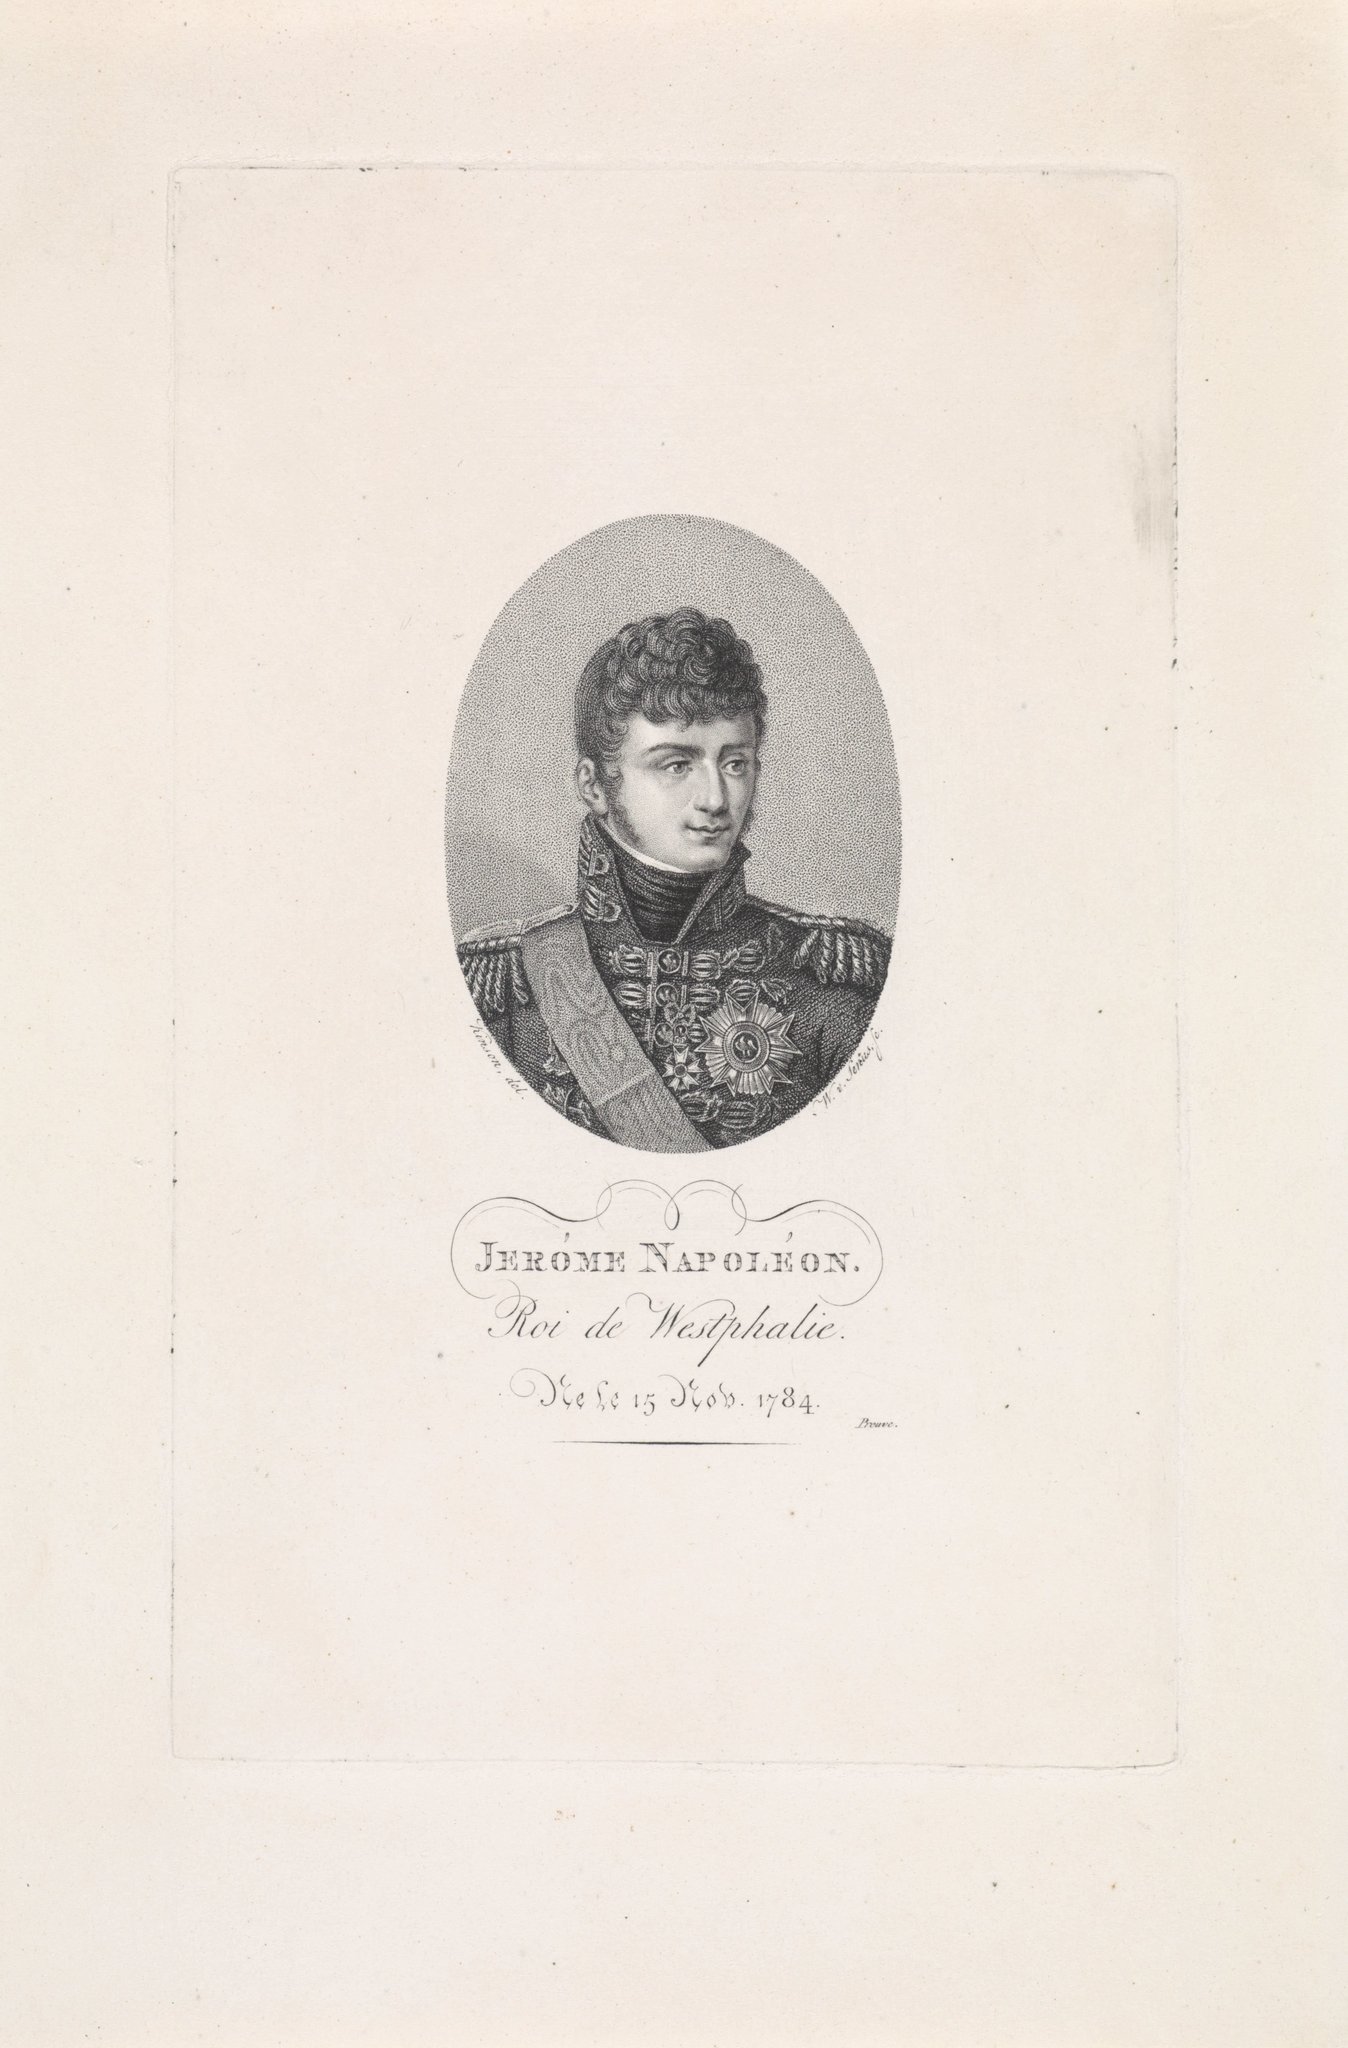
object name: print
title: Portret van Jerome Bonaparte (koning van Westfalen)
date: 1783-1851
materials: paper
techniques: engraving, etching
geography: netherlands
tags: paris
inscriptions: collector's mark: Lugt 2228